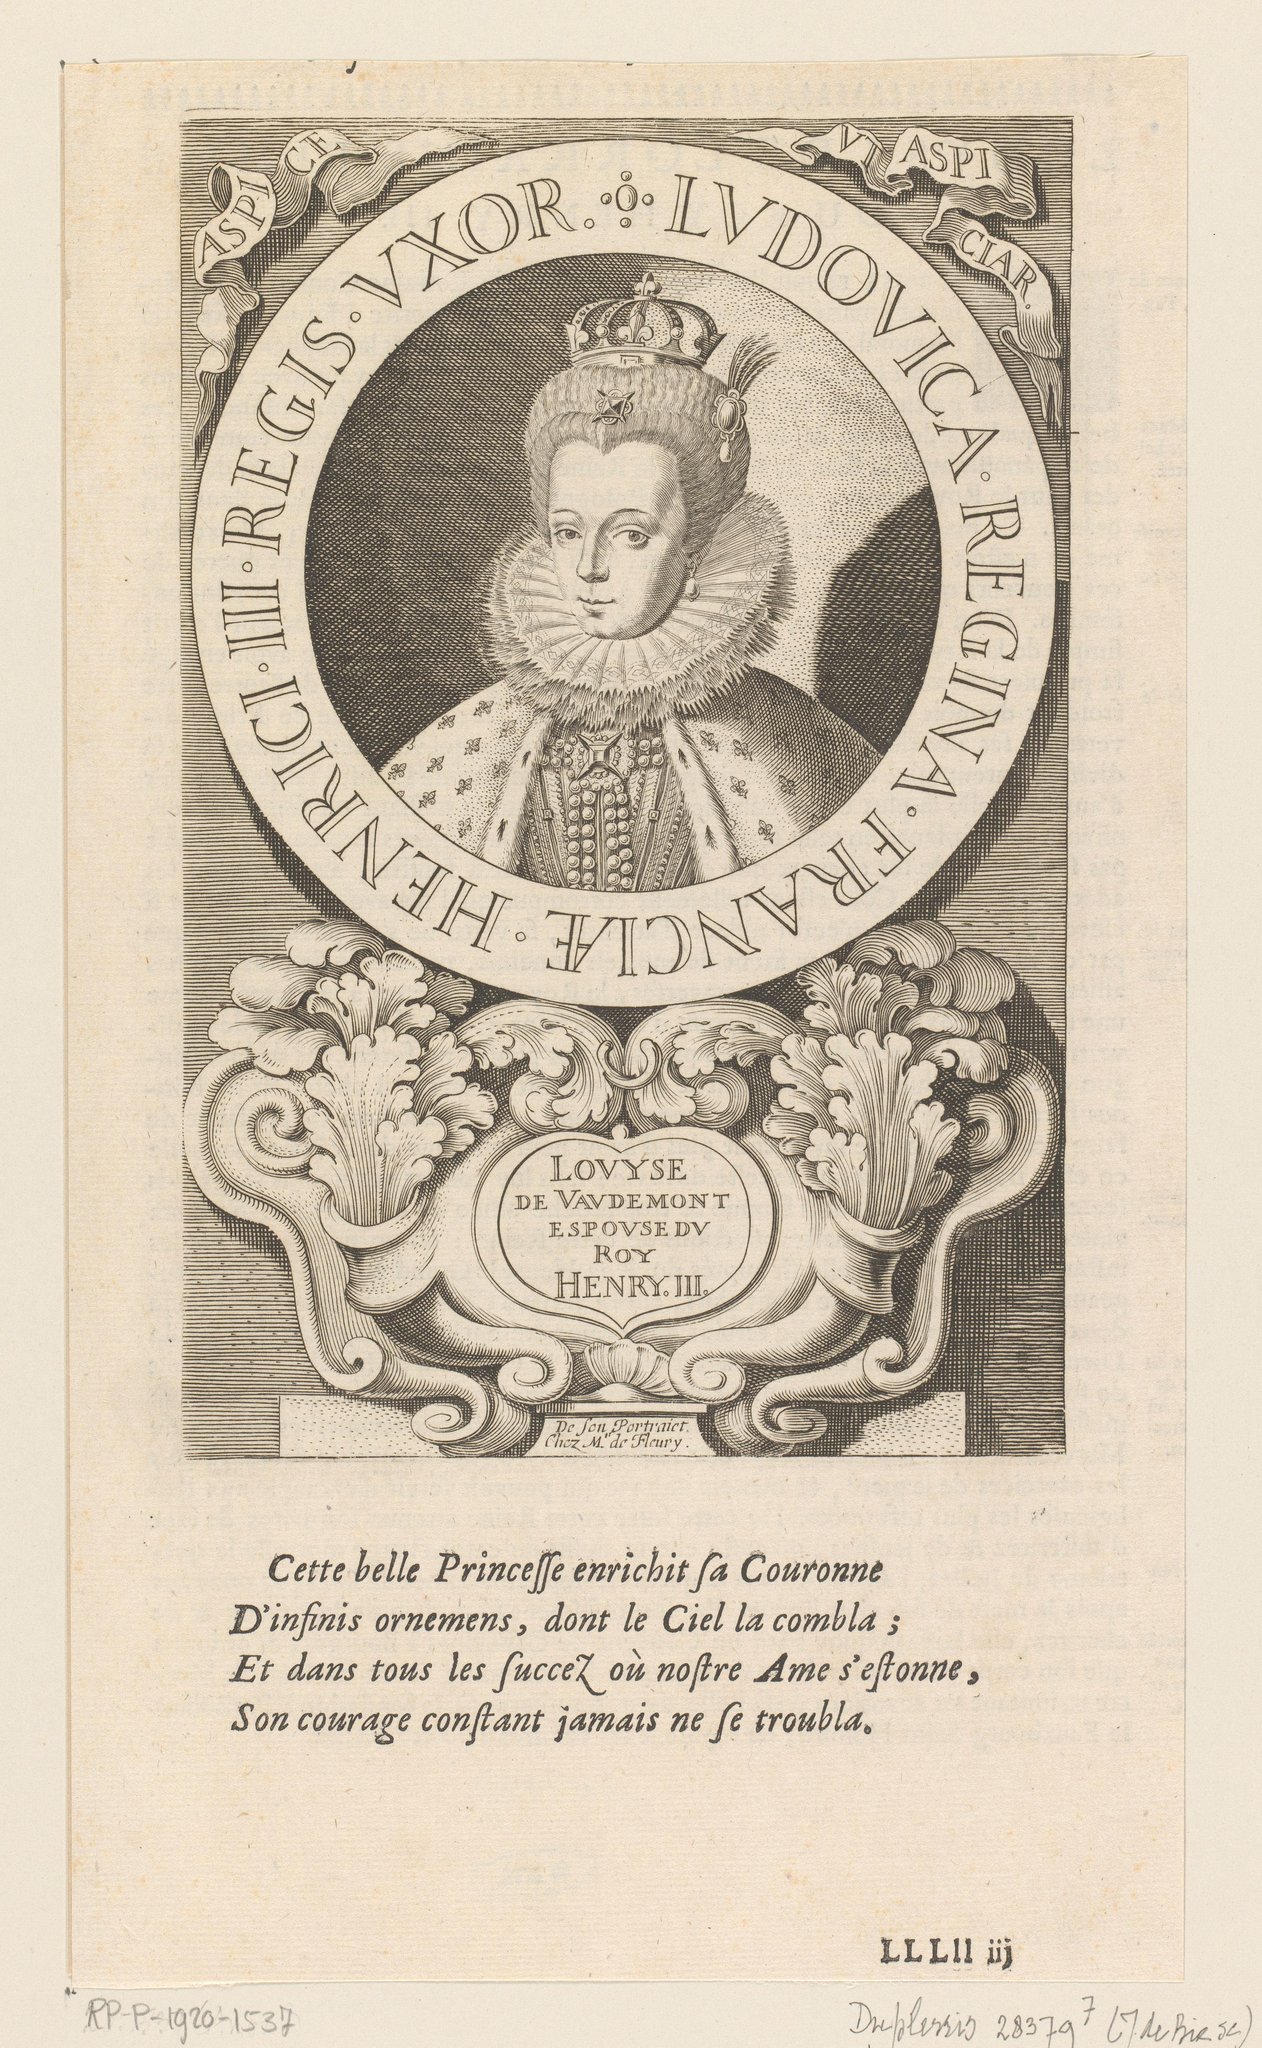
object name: book illustration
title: Louyse de Vaudemont espouse du roy Henry. III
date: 1635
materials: paper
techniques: engraving, letterpress printing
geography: paris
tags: historical persons, queen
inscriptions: collector's mark: Lugt 2228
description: Prent uit: Eudes de Mézeray, François. Histoire de France, depuis Faramond jusqu’au regne de Louis le Juste (...). 3 dln. Parijs: Denis Thierry, Jean Guignard en Claude Barbin, 1635, dl. 3. Prent waarschijnlijk voor het eerst verschenen in: Bie, Jacques de. Les vrais portraits des rois de France (...). Parijs: Jacques de Bie en Pierre Rocolet, 1634. Prent ook gebruikt in latere publicaties.